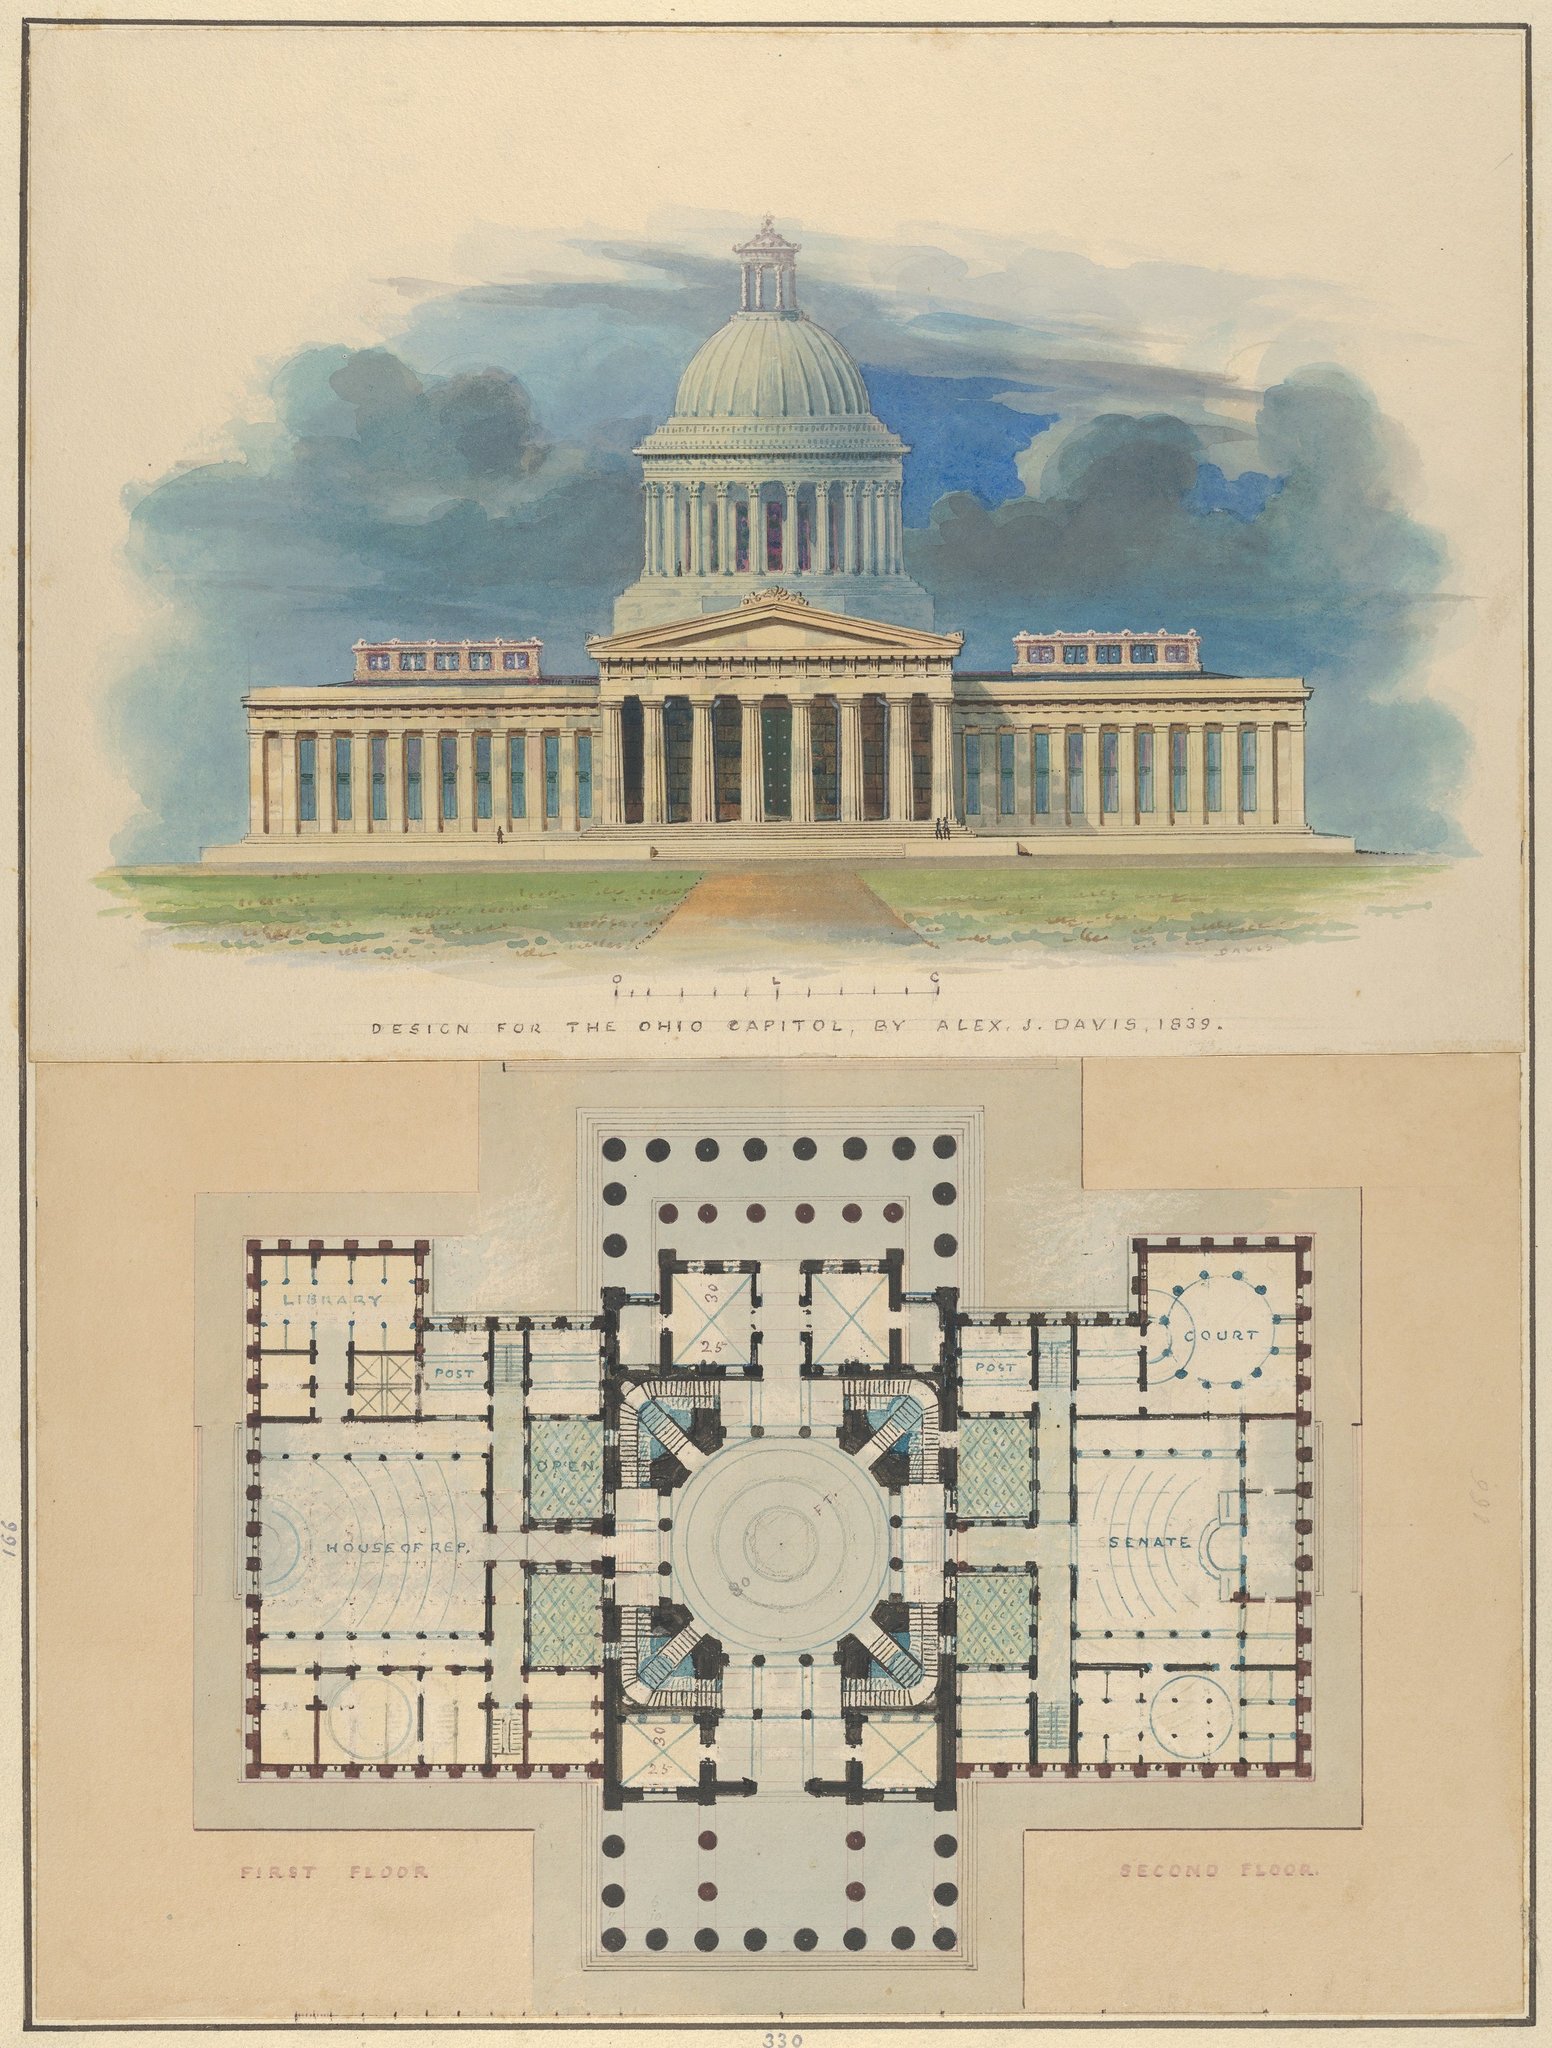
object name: drawing ornament architecture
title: Design for the Capitol of Ohio, Columbus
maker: alexander jackson davis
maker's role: artist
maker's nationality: american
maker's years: 1803-1892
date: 1839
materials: graphite, ink, watercolor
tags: architecture,buildings